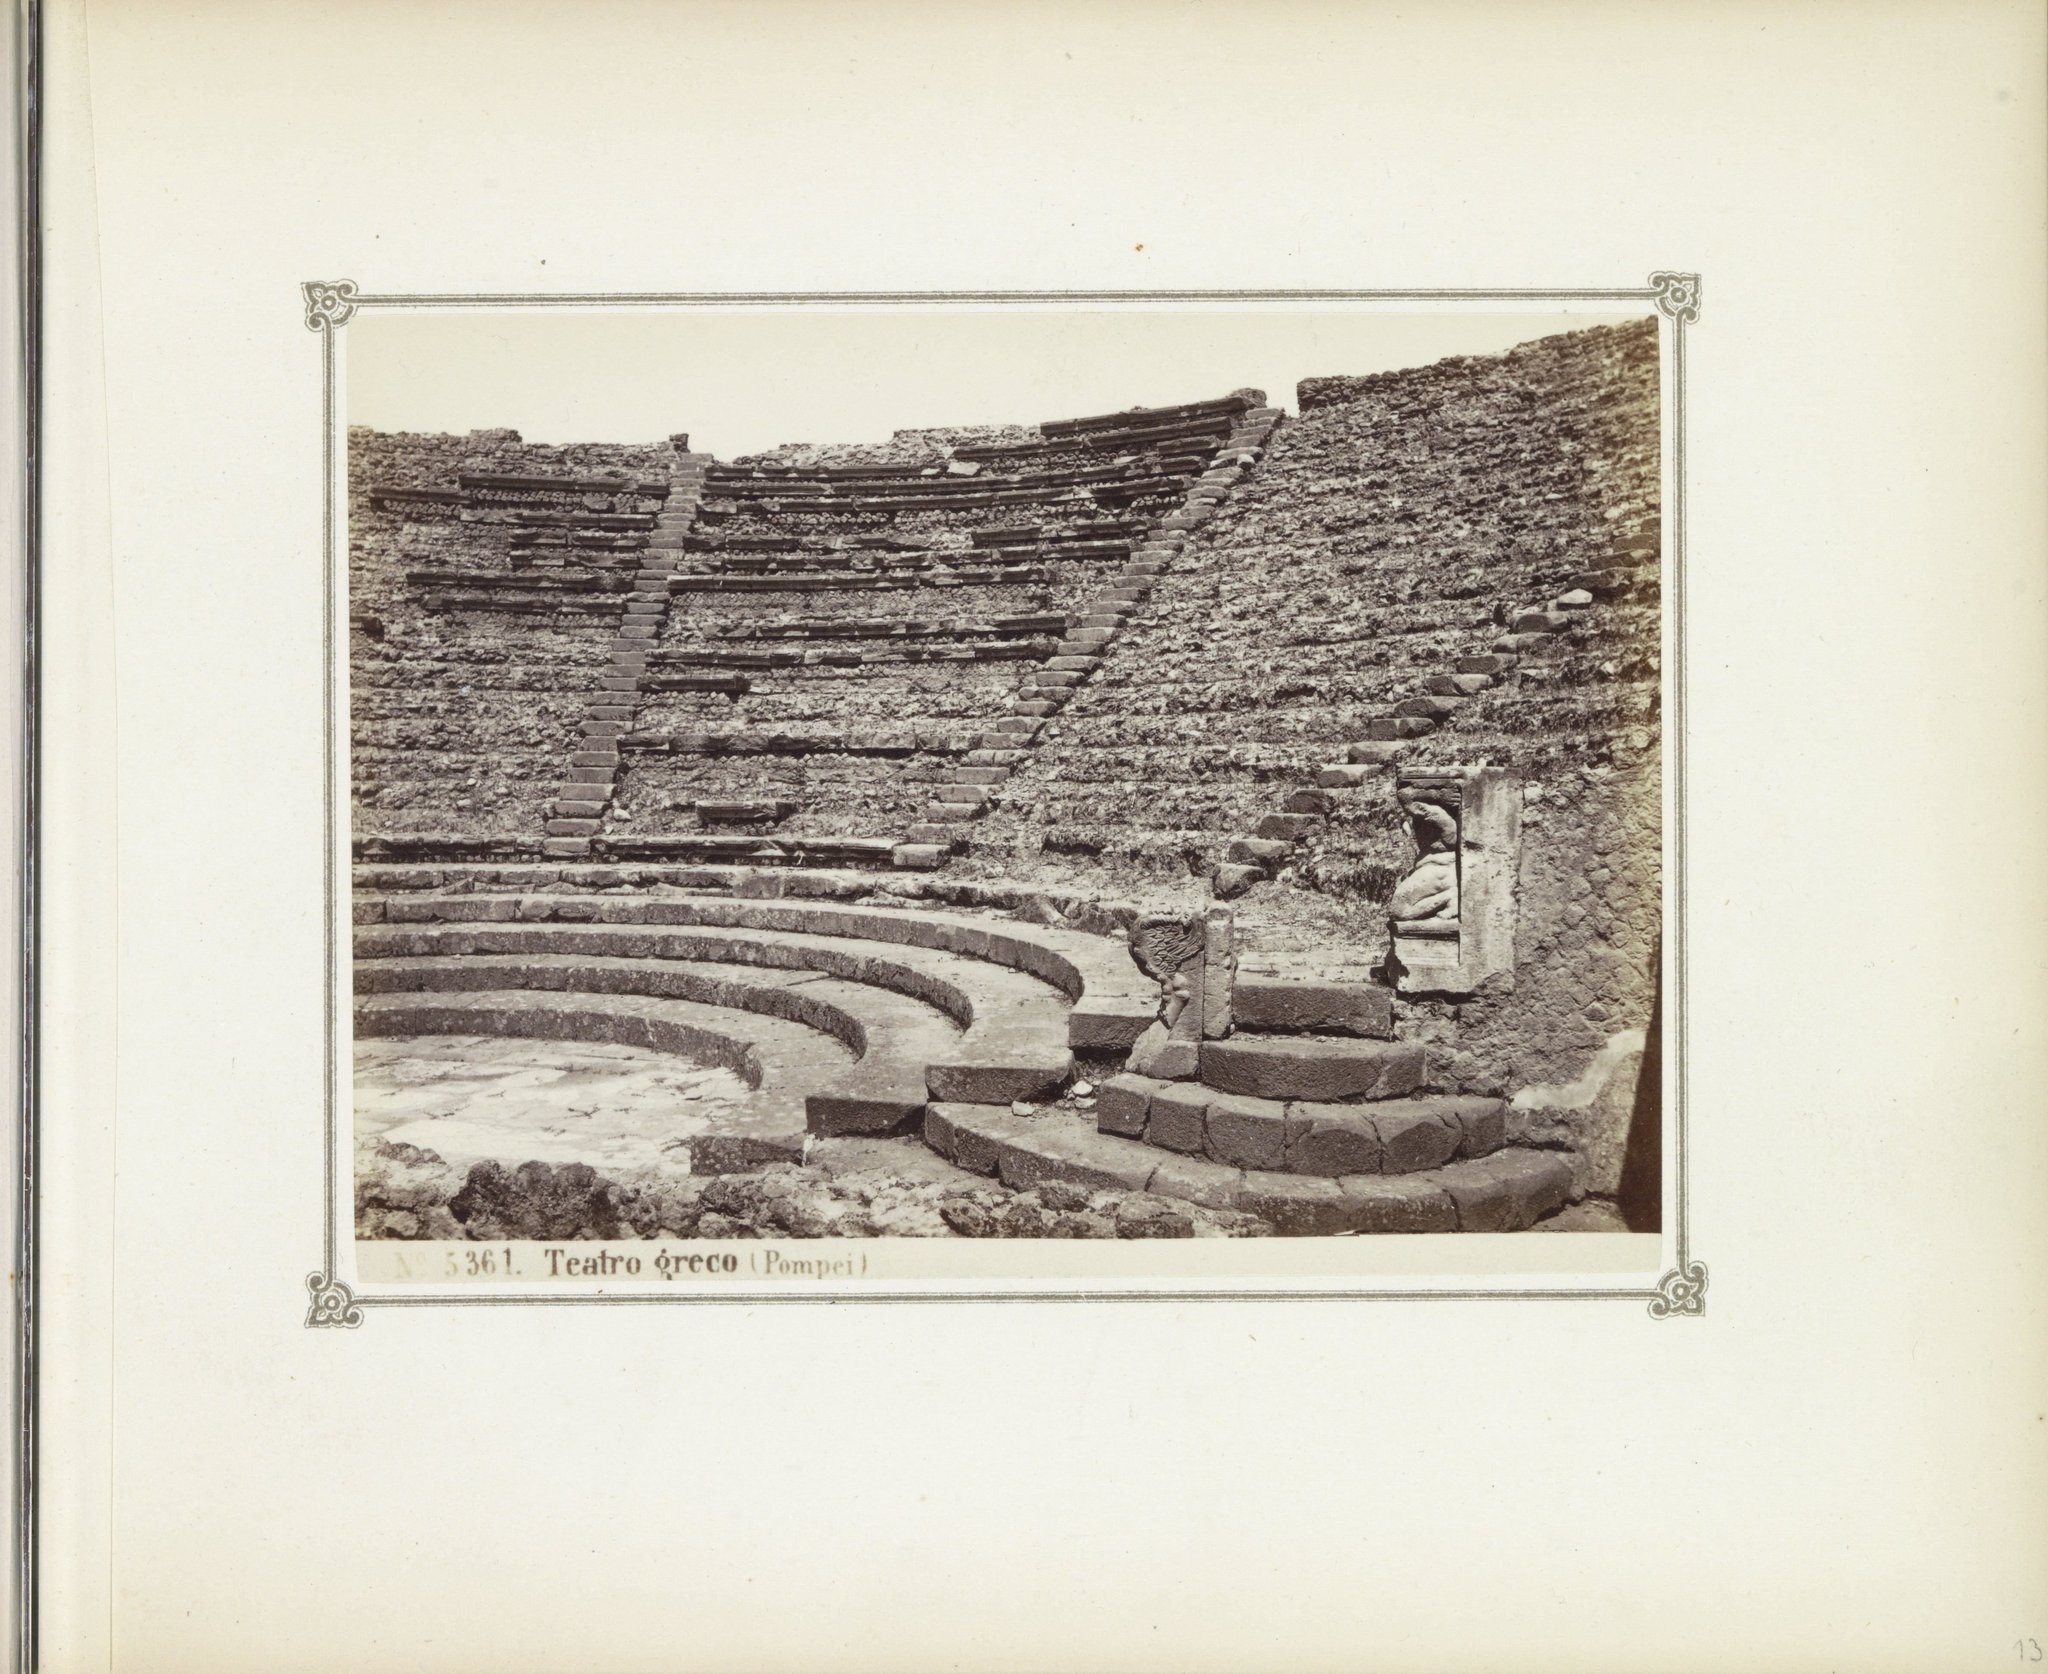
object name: album leaf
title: Teatro greco (Pompei)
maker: giorgio sommer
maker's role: fotograaf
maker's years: 1834-1914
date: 1860-1900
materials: paper, photographic support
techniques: albumen print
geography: pompeii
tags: excavation ~ archaeology, pompeii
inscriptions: number: ‘5863’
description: Onderdeel van Fotoalbum met opnames van opgravingen in Pompeï door Giorgio Sommer.